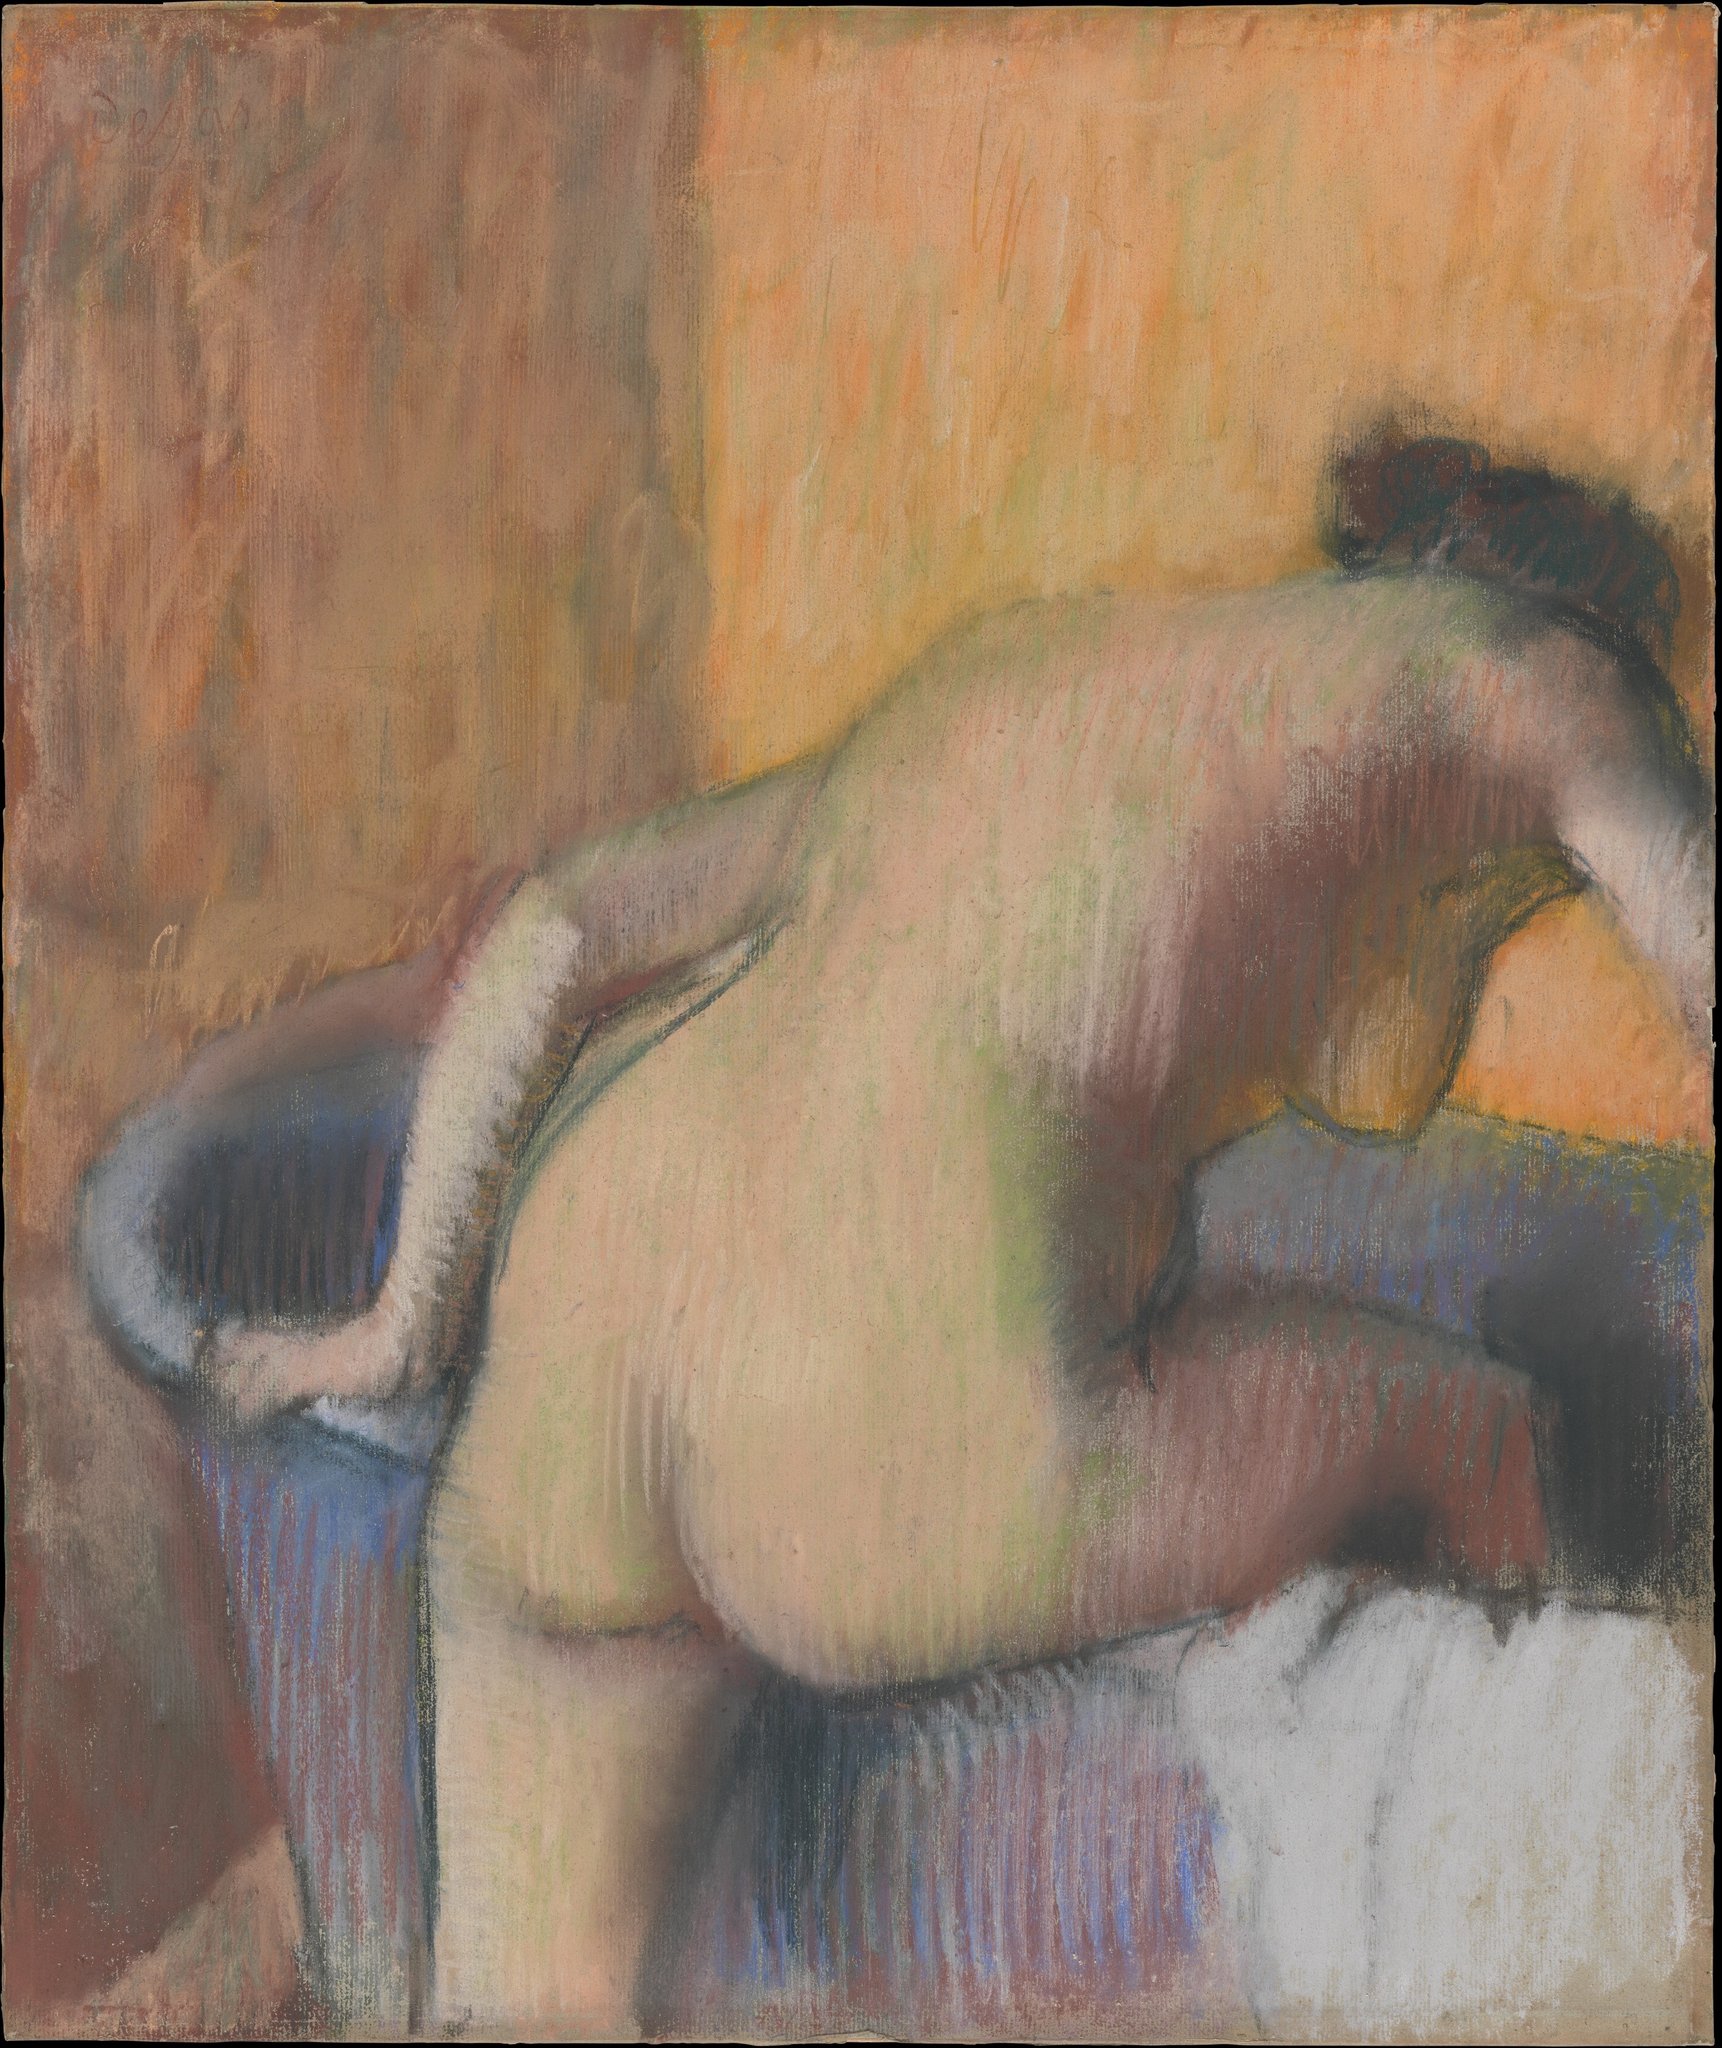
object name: drawing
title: Bather Stepping into a Tub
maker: edgar degas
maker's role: artist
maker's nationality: french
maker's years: 1834-1917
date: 1890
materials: board, charcoal, paper, pastel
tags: female nudes,bathing